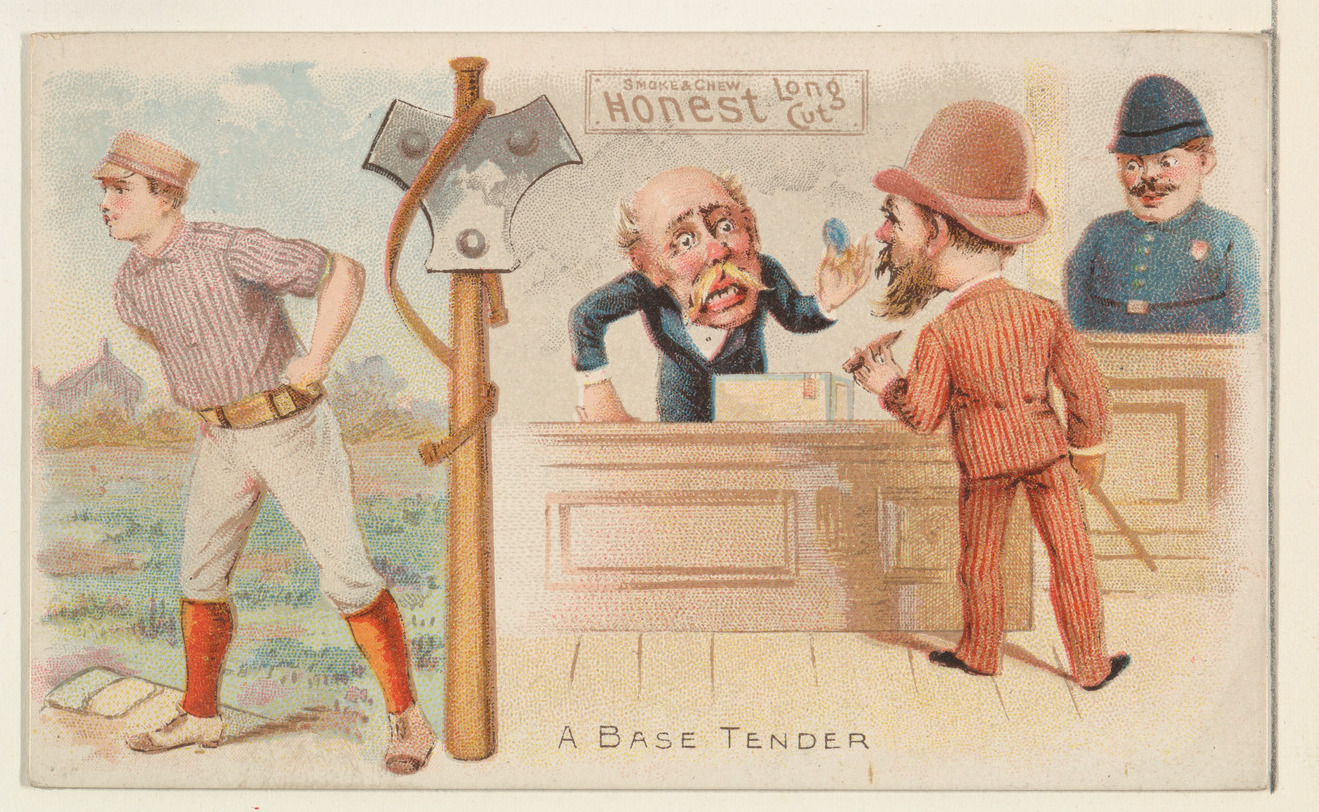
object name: print, baseball card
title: A Base Tender, from the Talk of the Diamond set (N135) issued by Duke Sons & Co., a branch of the American Tobacco Company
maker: w. duke, sons & co.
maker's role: publisher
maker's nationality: american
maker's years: 1870-1920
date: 1888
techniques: color lithograph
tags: men